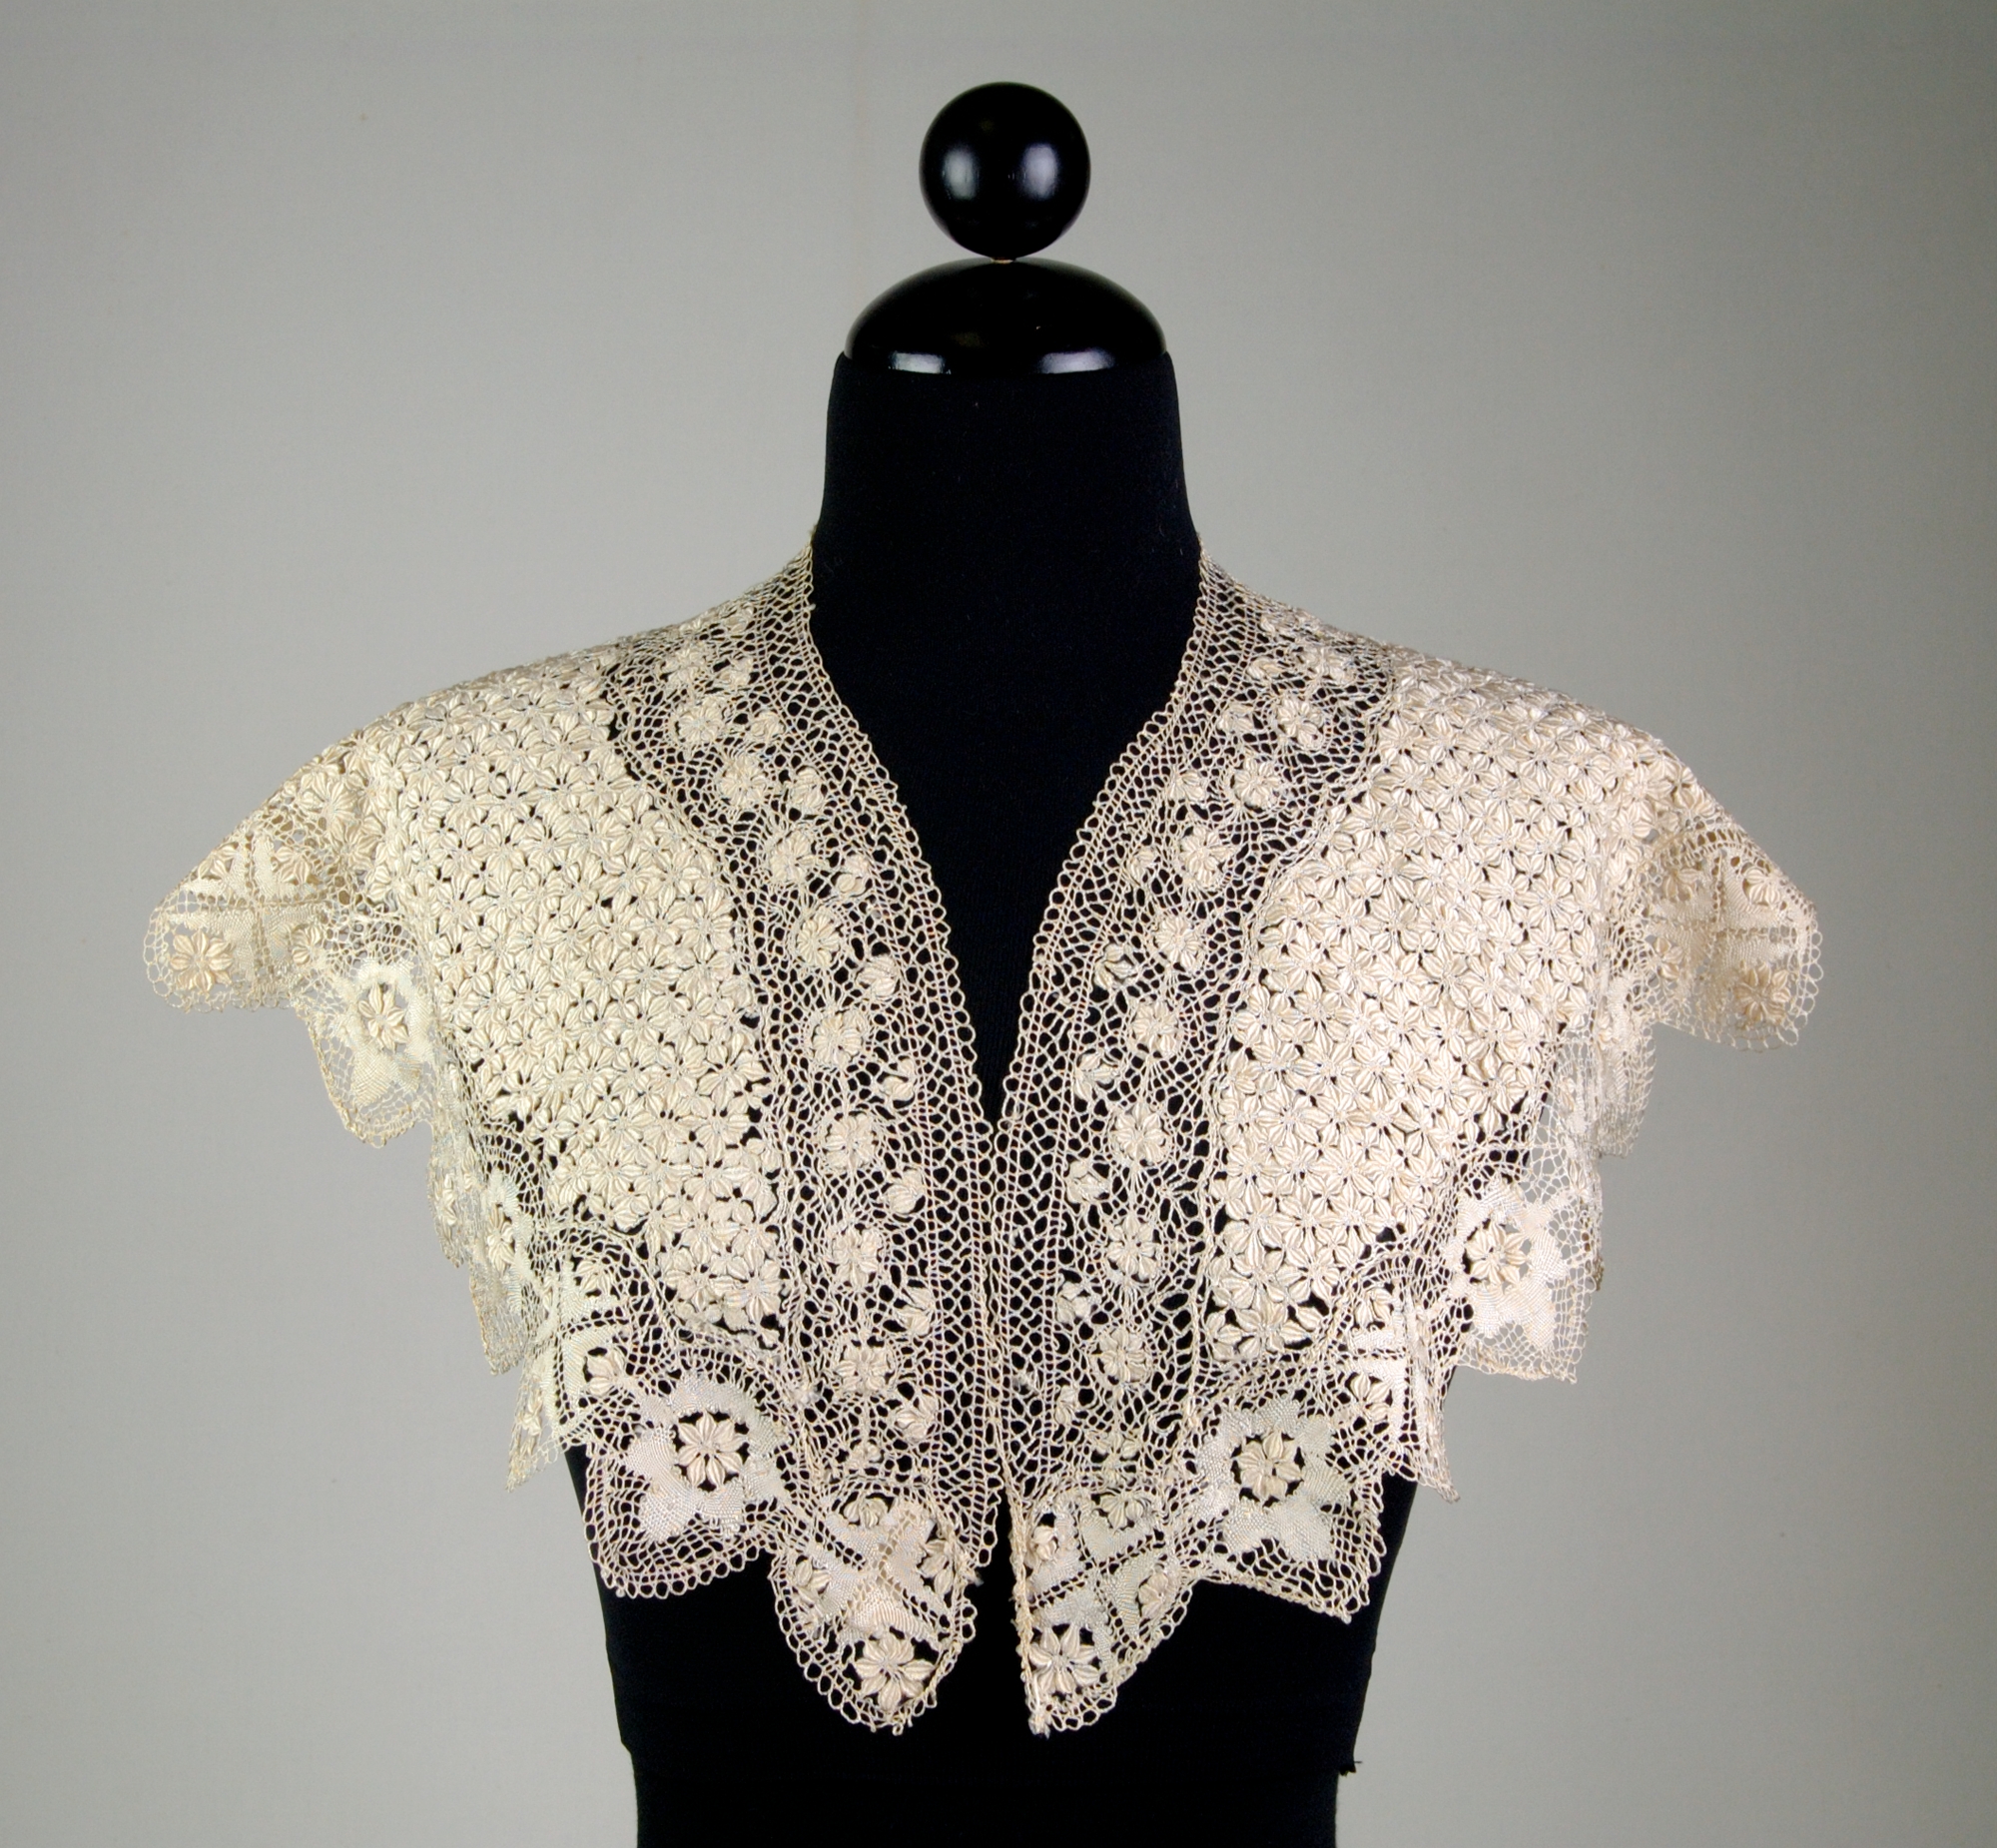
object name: pelerine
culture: maltese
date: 1851-1875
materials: silk